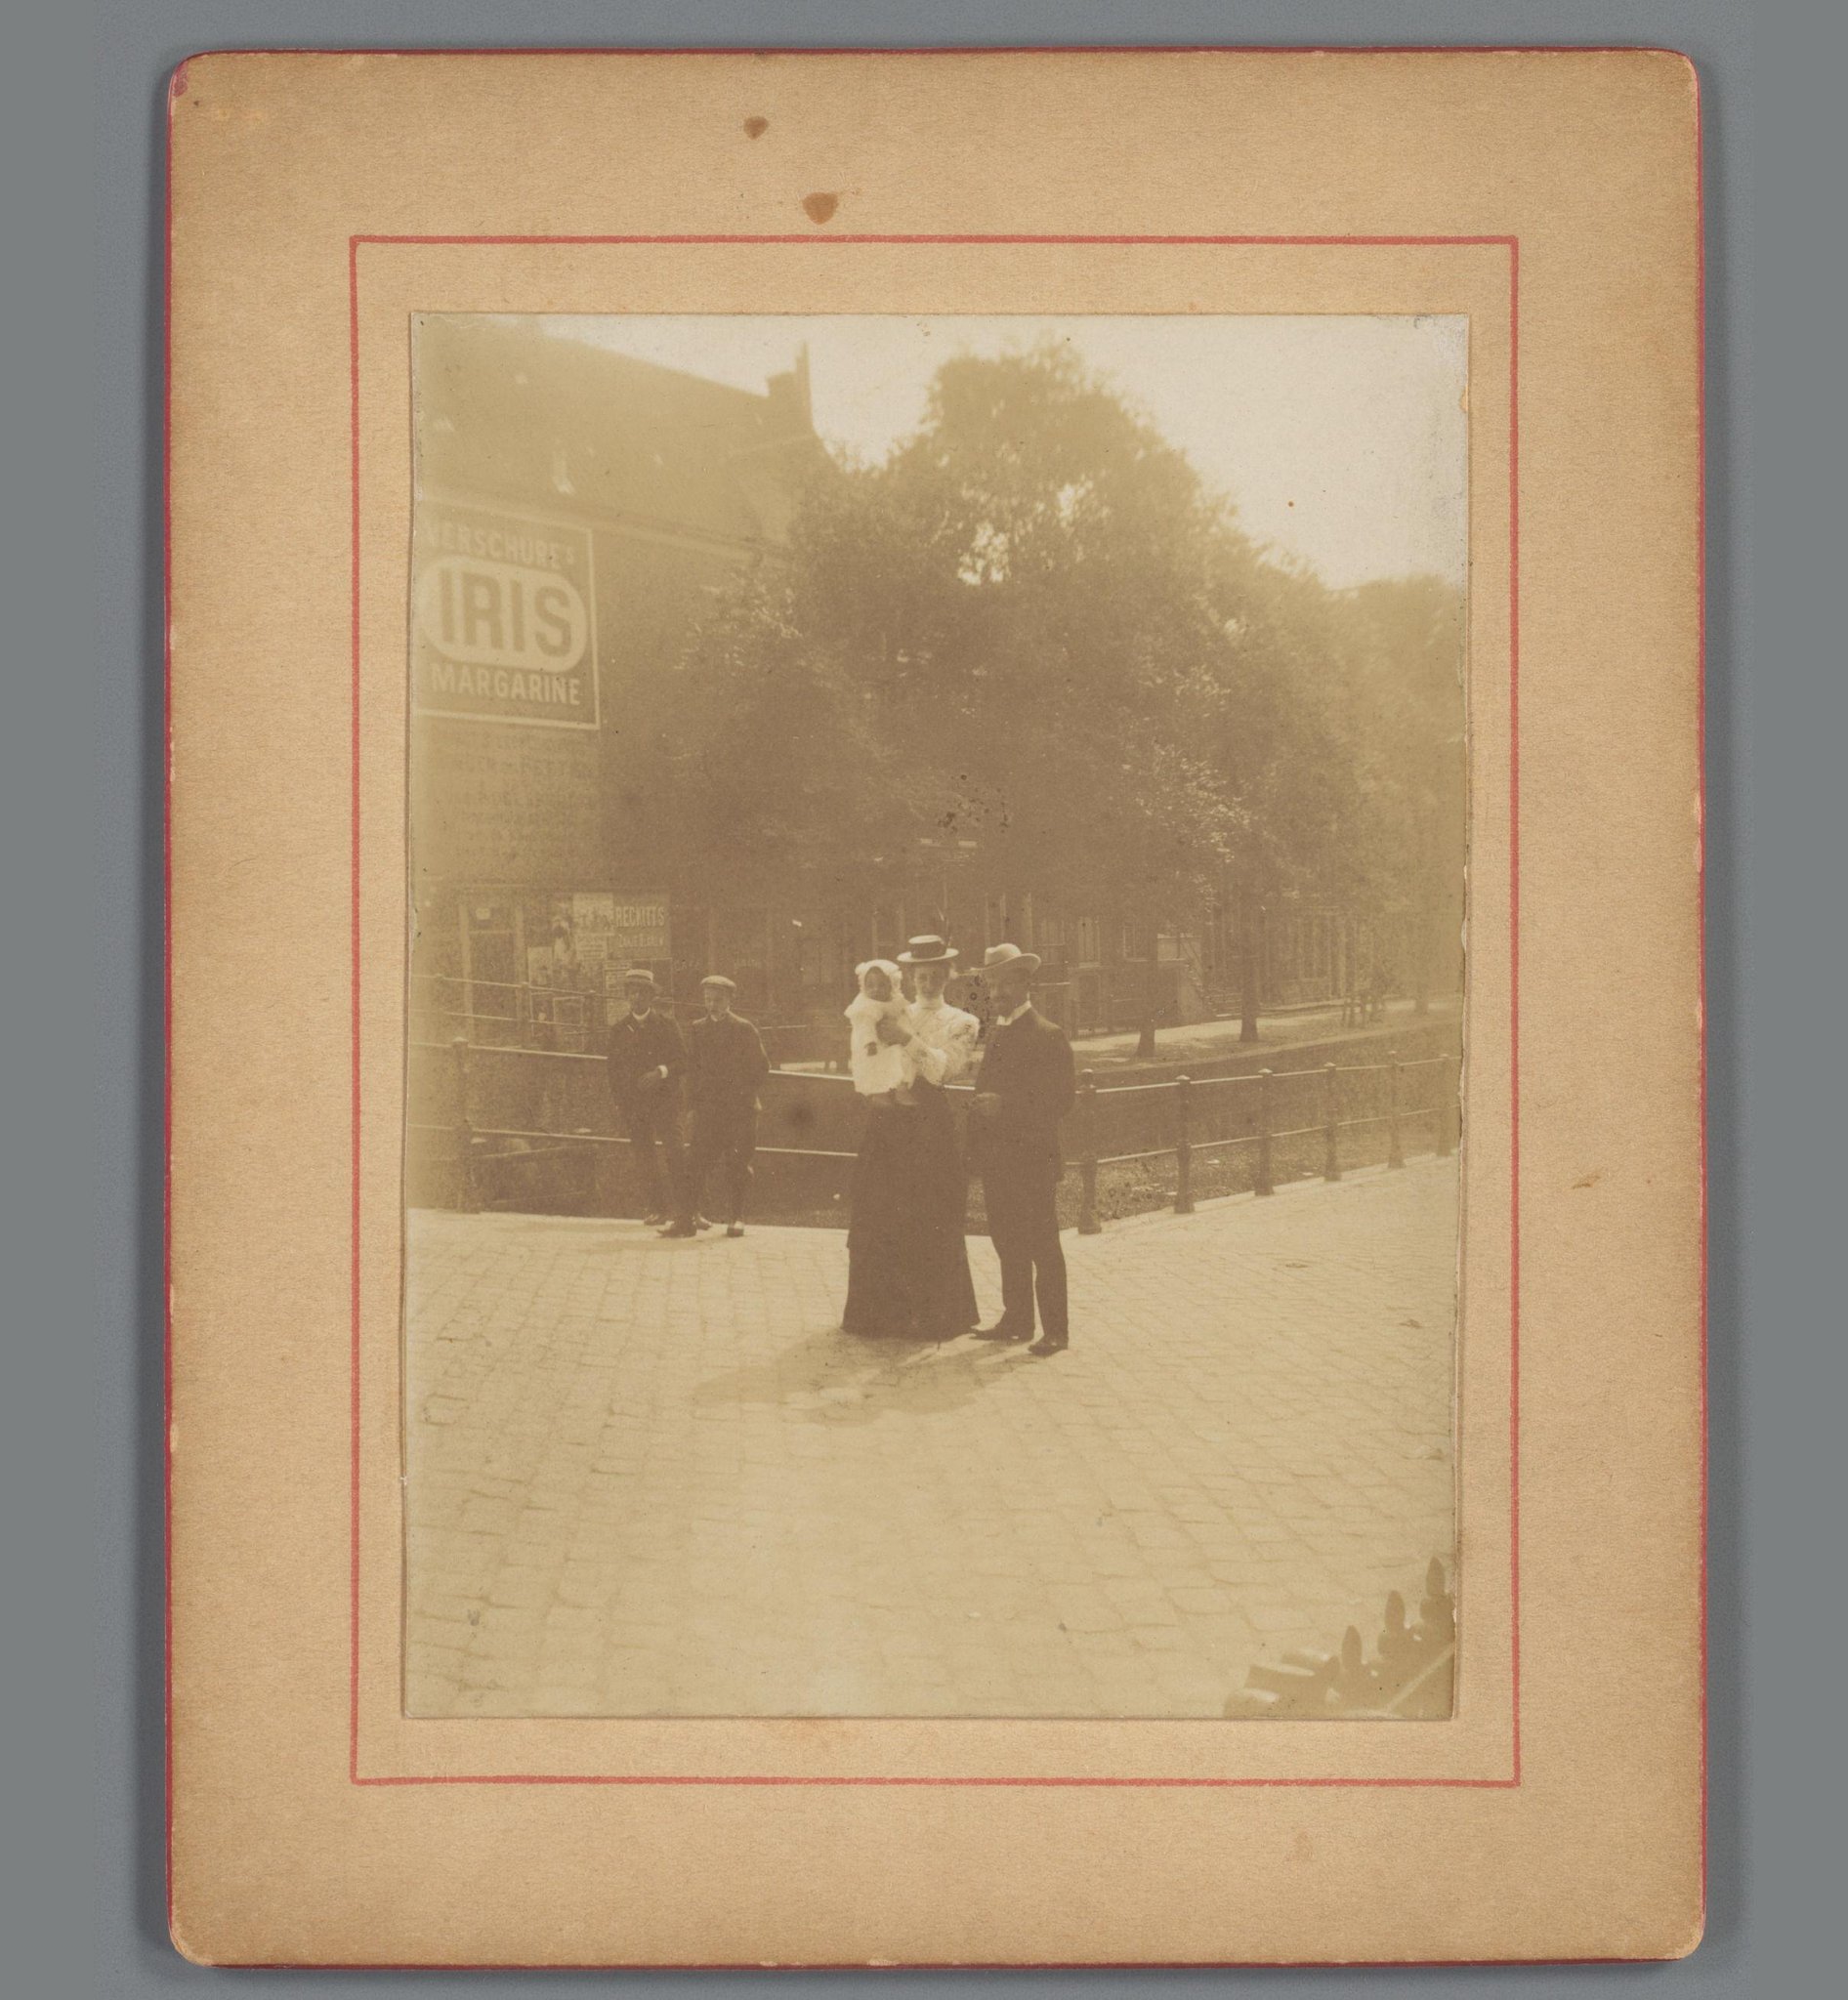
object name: photograph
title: Groepsportret van een onbekende man, vrouw en kind op een gracht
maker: Anonymous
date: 1895-1910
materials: paper, cardboard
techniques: matte daylight collodion silver print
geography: france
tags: family group, especially parents with their child(ren), canals, waters (in city), anonymous historical persons portrayed in a group, in a group-portrait, netherlands